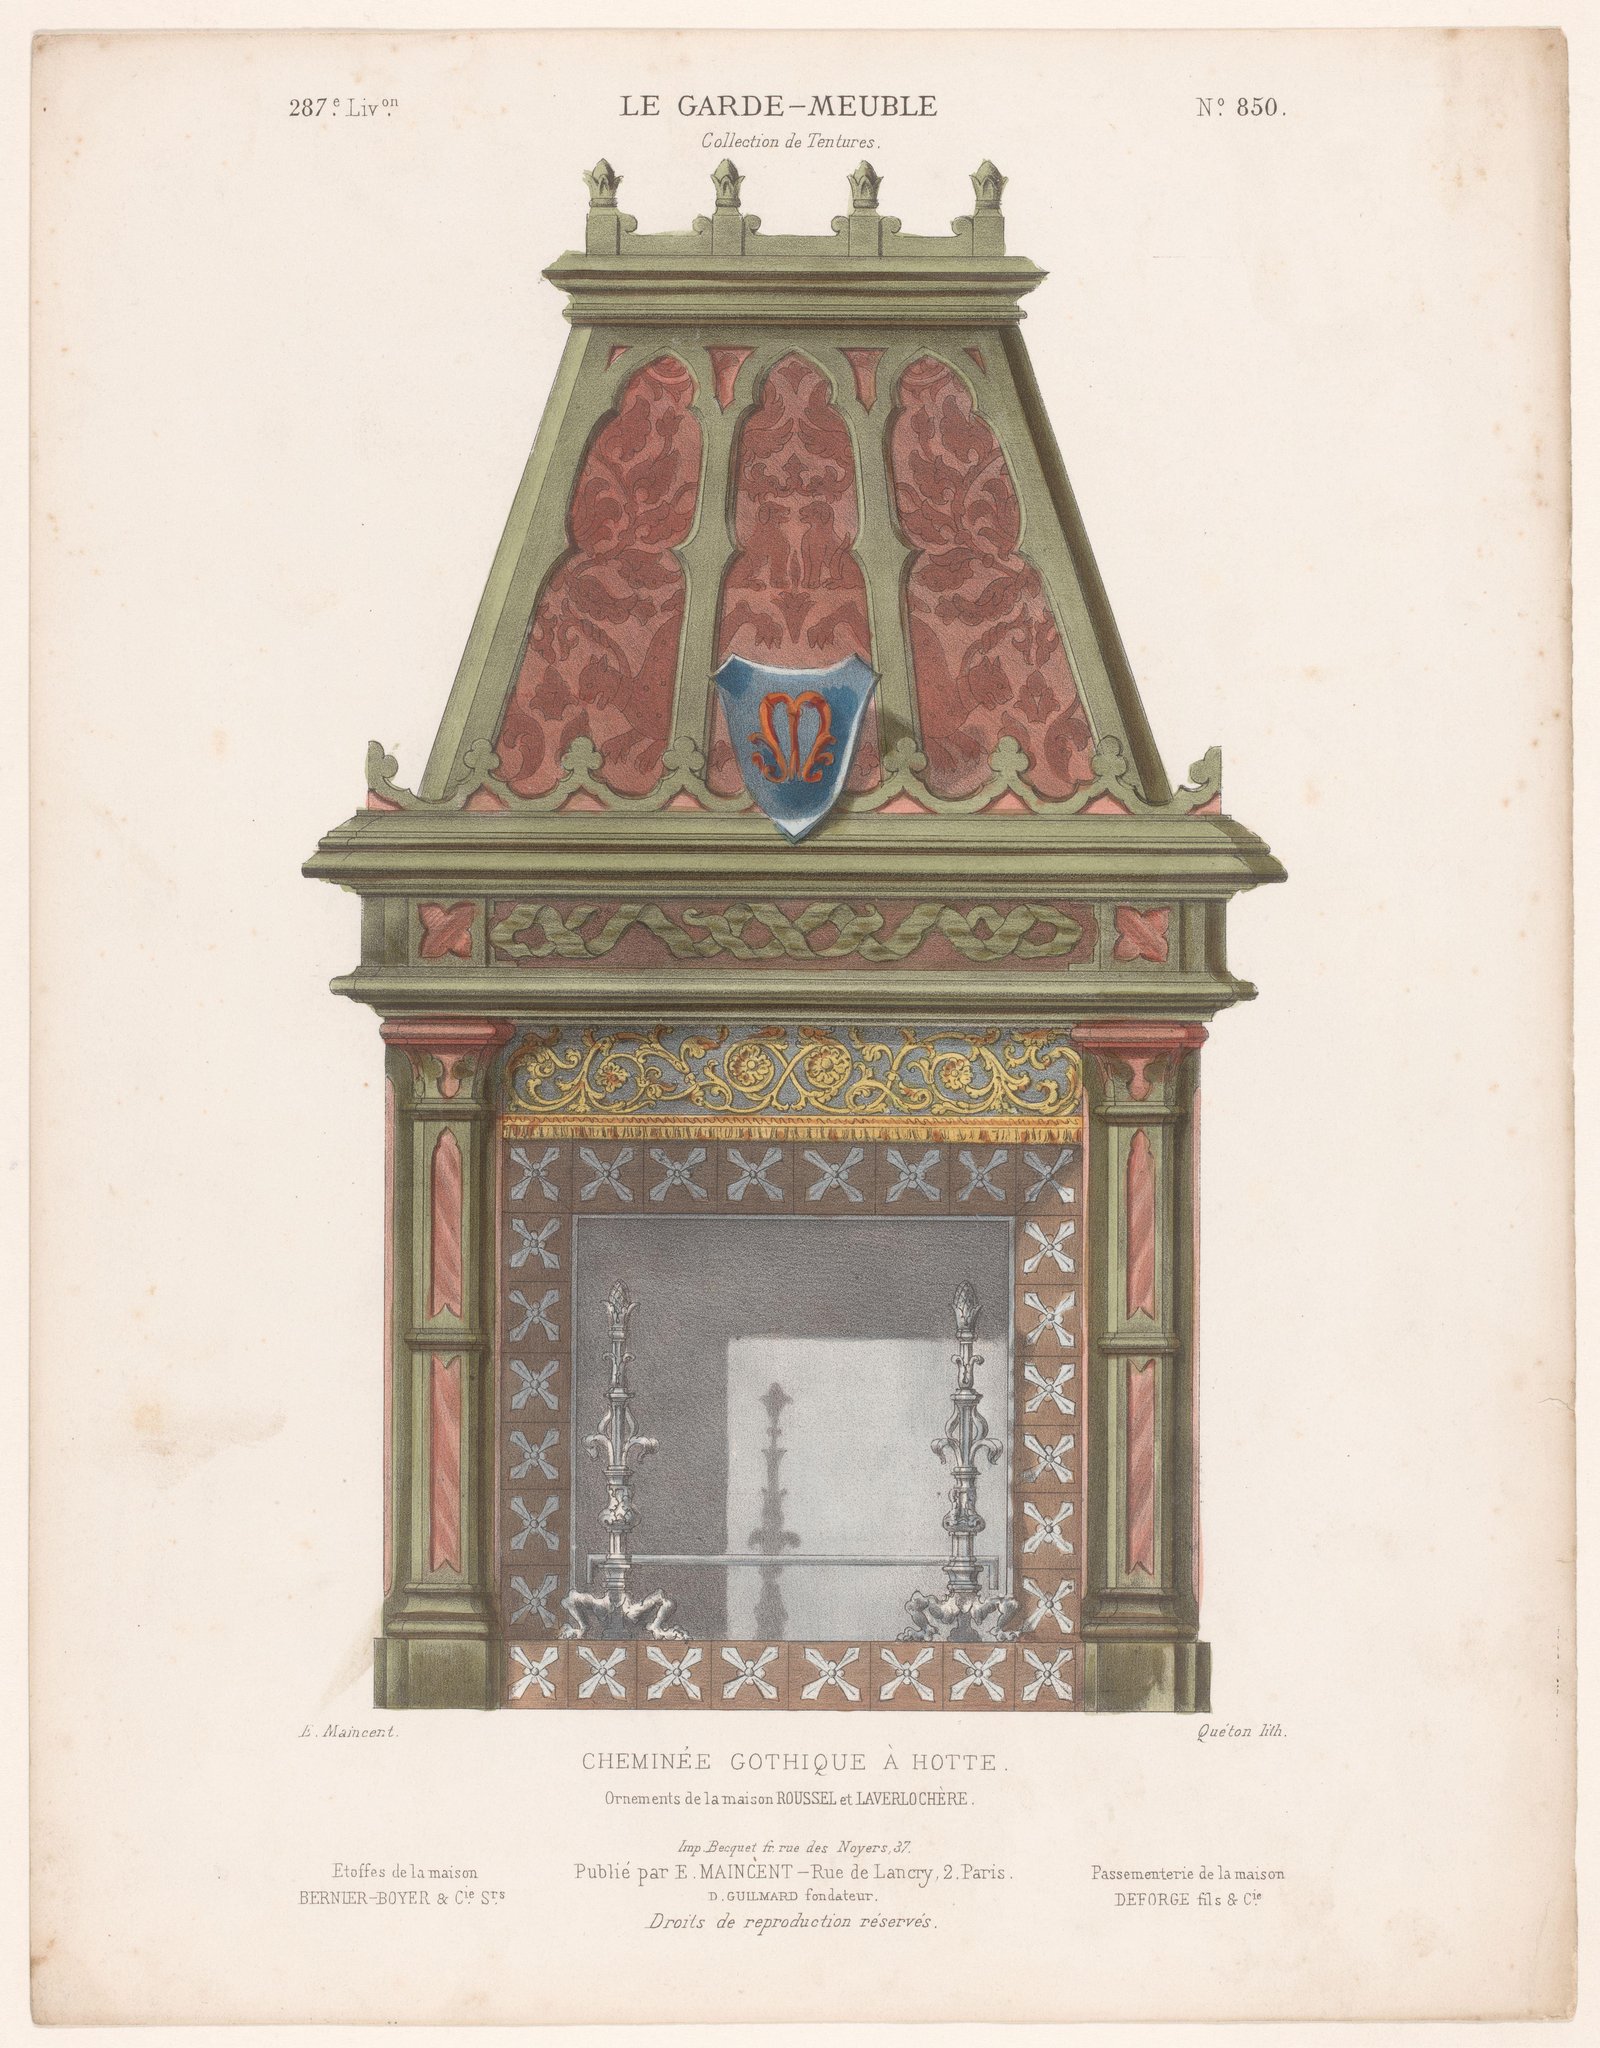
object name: print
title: Le Garde-Meuble / Collection de Tentures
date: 1885-1895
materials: paper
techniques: hand coloring, lithograph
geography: paris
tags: decorations (interior of the house), open hearth, fire-place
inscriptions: : ‘Droits de reproduction réservés.’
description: Haard met decoratieve kap in gotische stijl. Prent uit 287e Livraison.